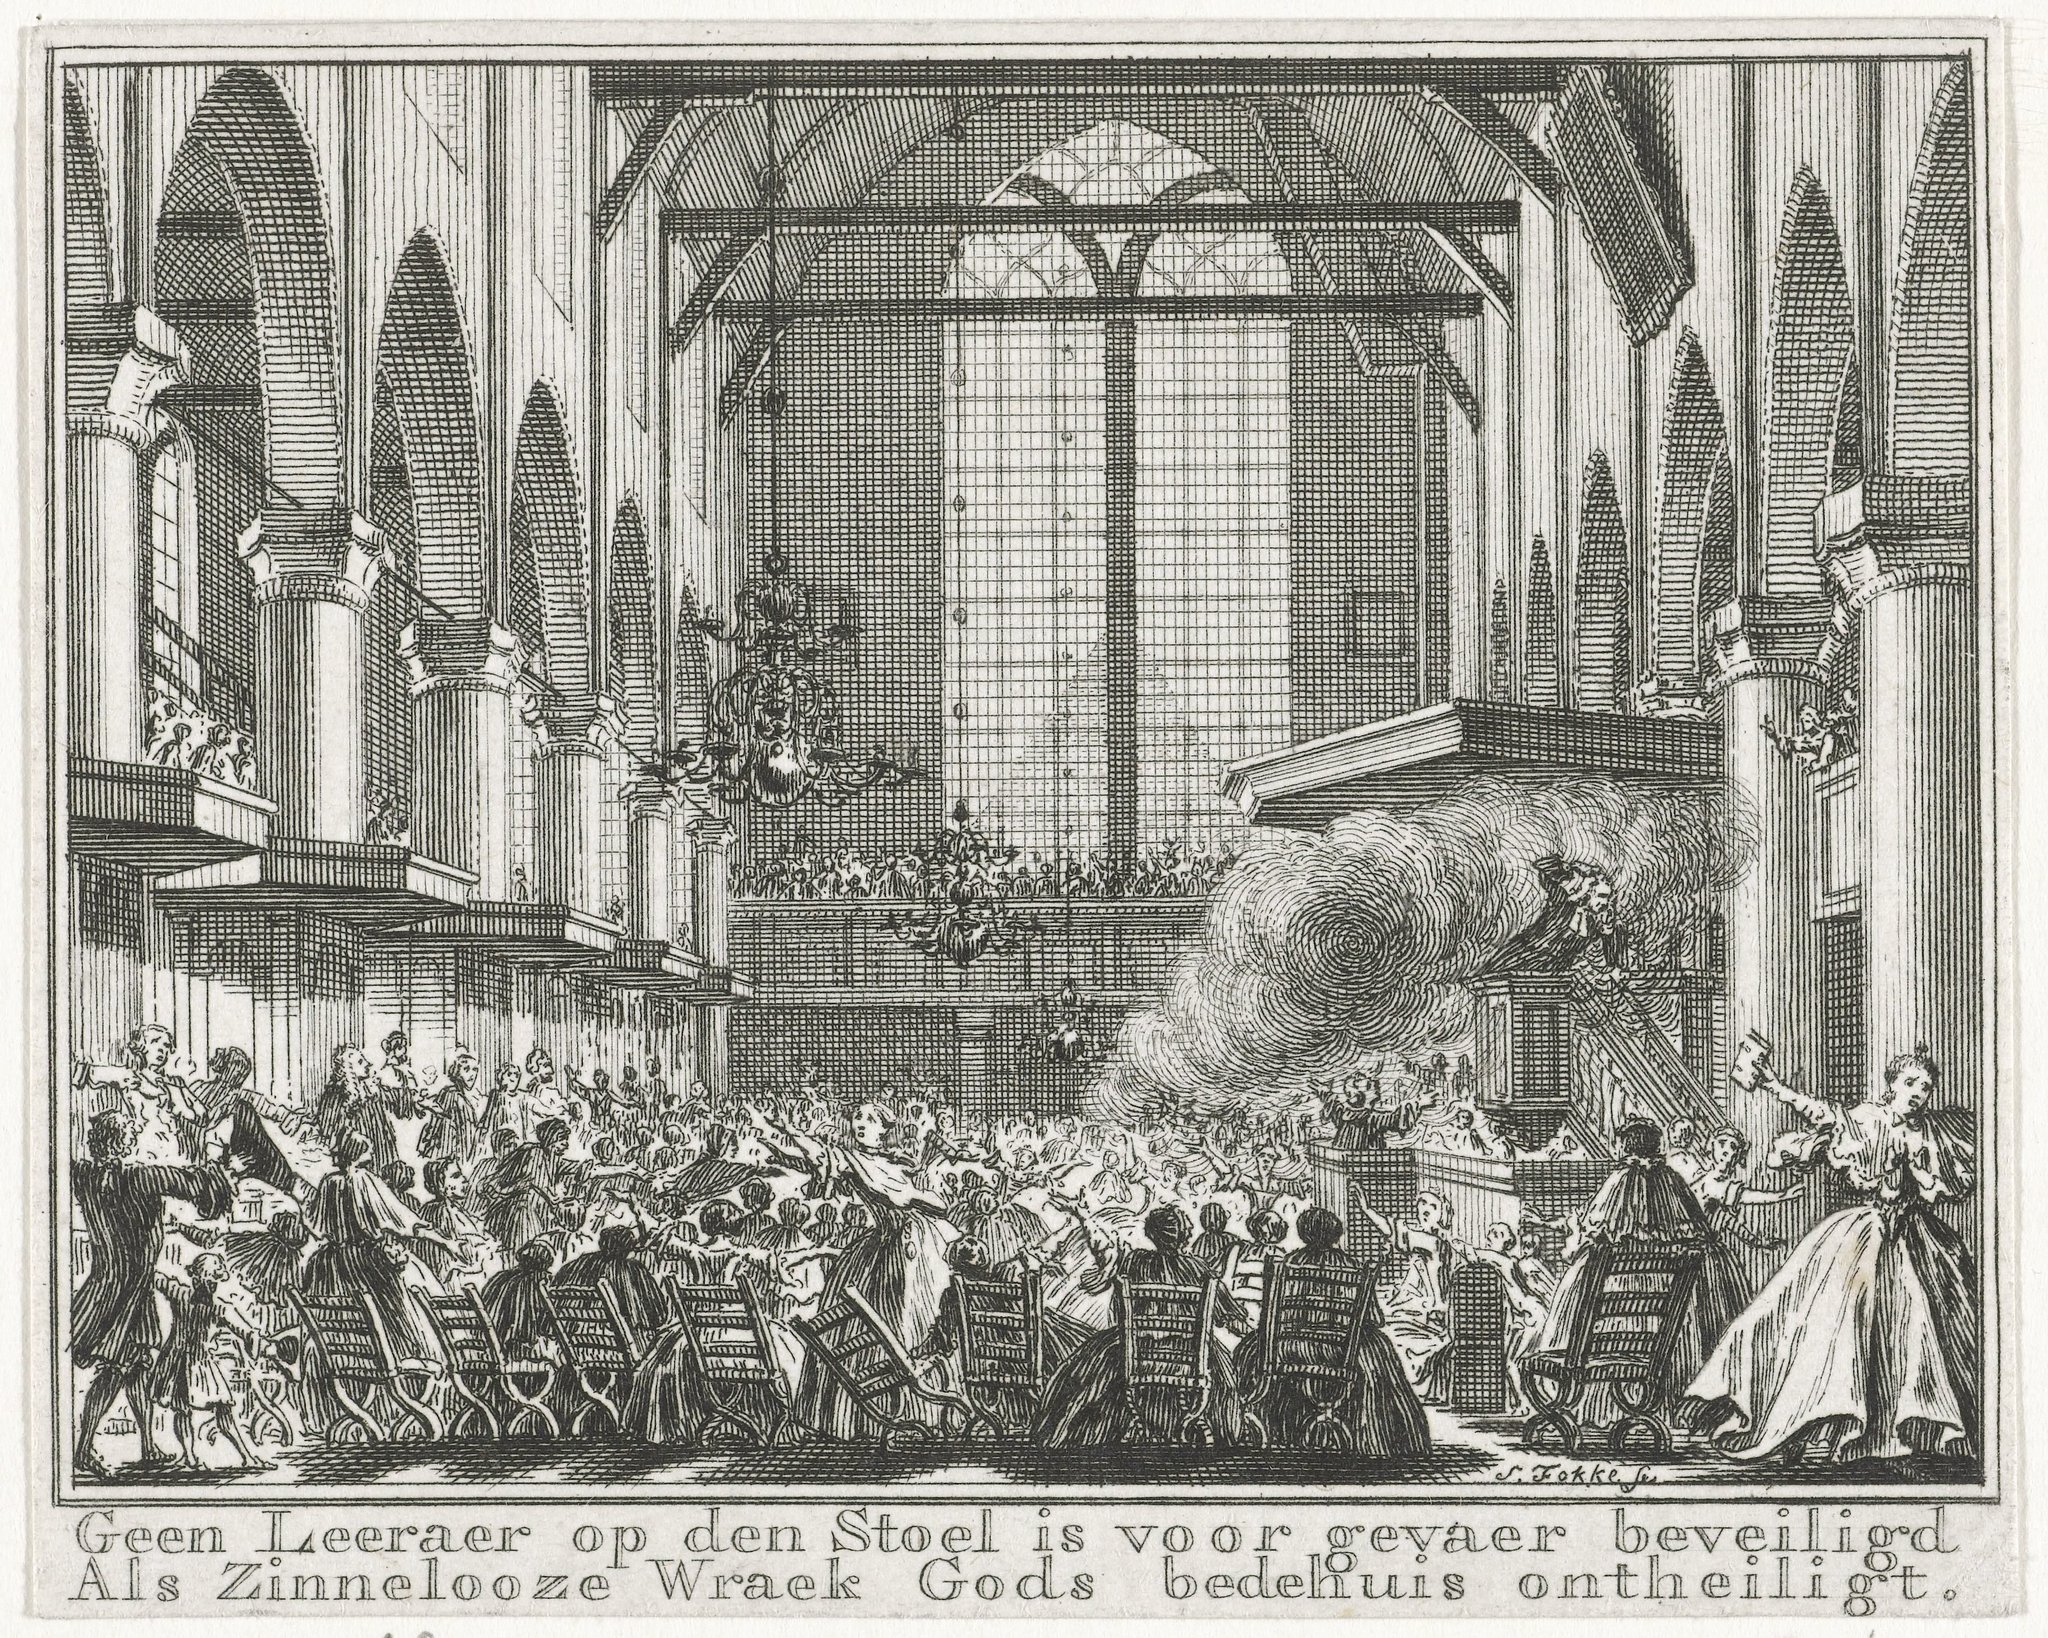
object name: print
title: Aanslag in de Waalse Kerk te Amsterdam, 1755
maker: simon fokke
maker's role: draughtsman, print maker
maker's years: 1712-1784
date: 1755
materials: paper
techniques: etching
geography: amsterdam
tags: interior of church, murder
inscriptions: collector's mark: Lugt 240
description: Aanslag in de Waalse Kerk van een fanatieke bakkersknecht op de predikant François tijdens de dienst. Onder de voorstelling een tweeregelig onderschrift.